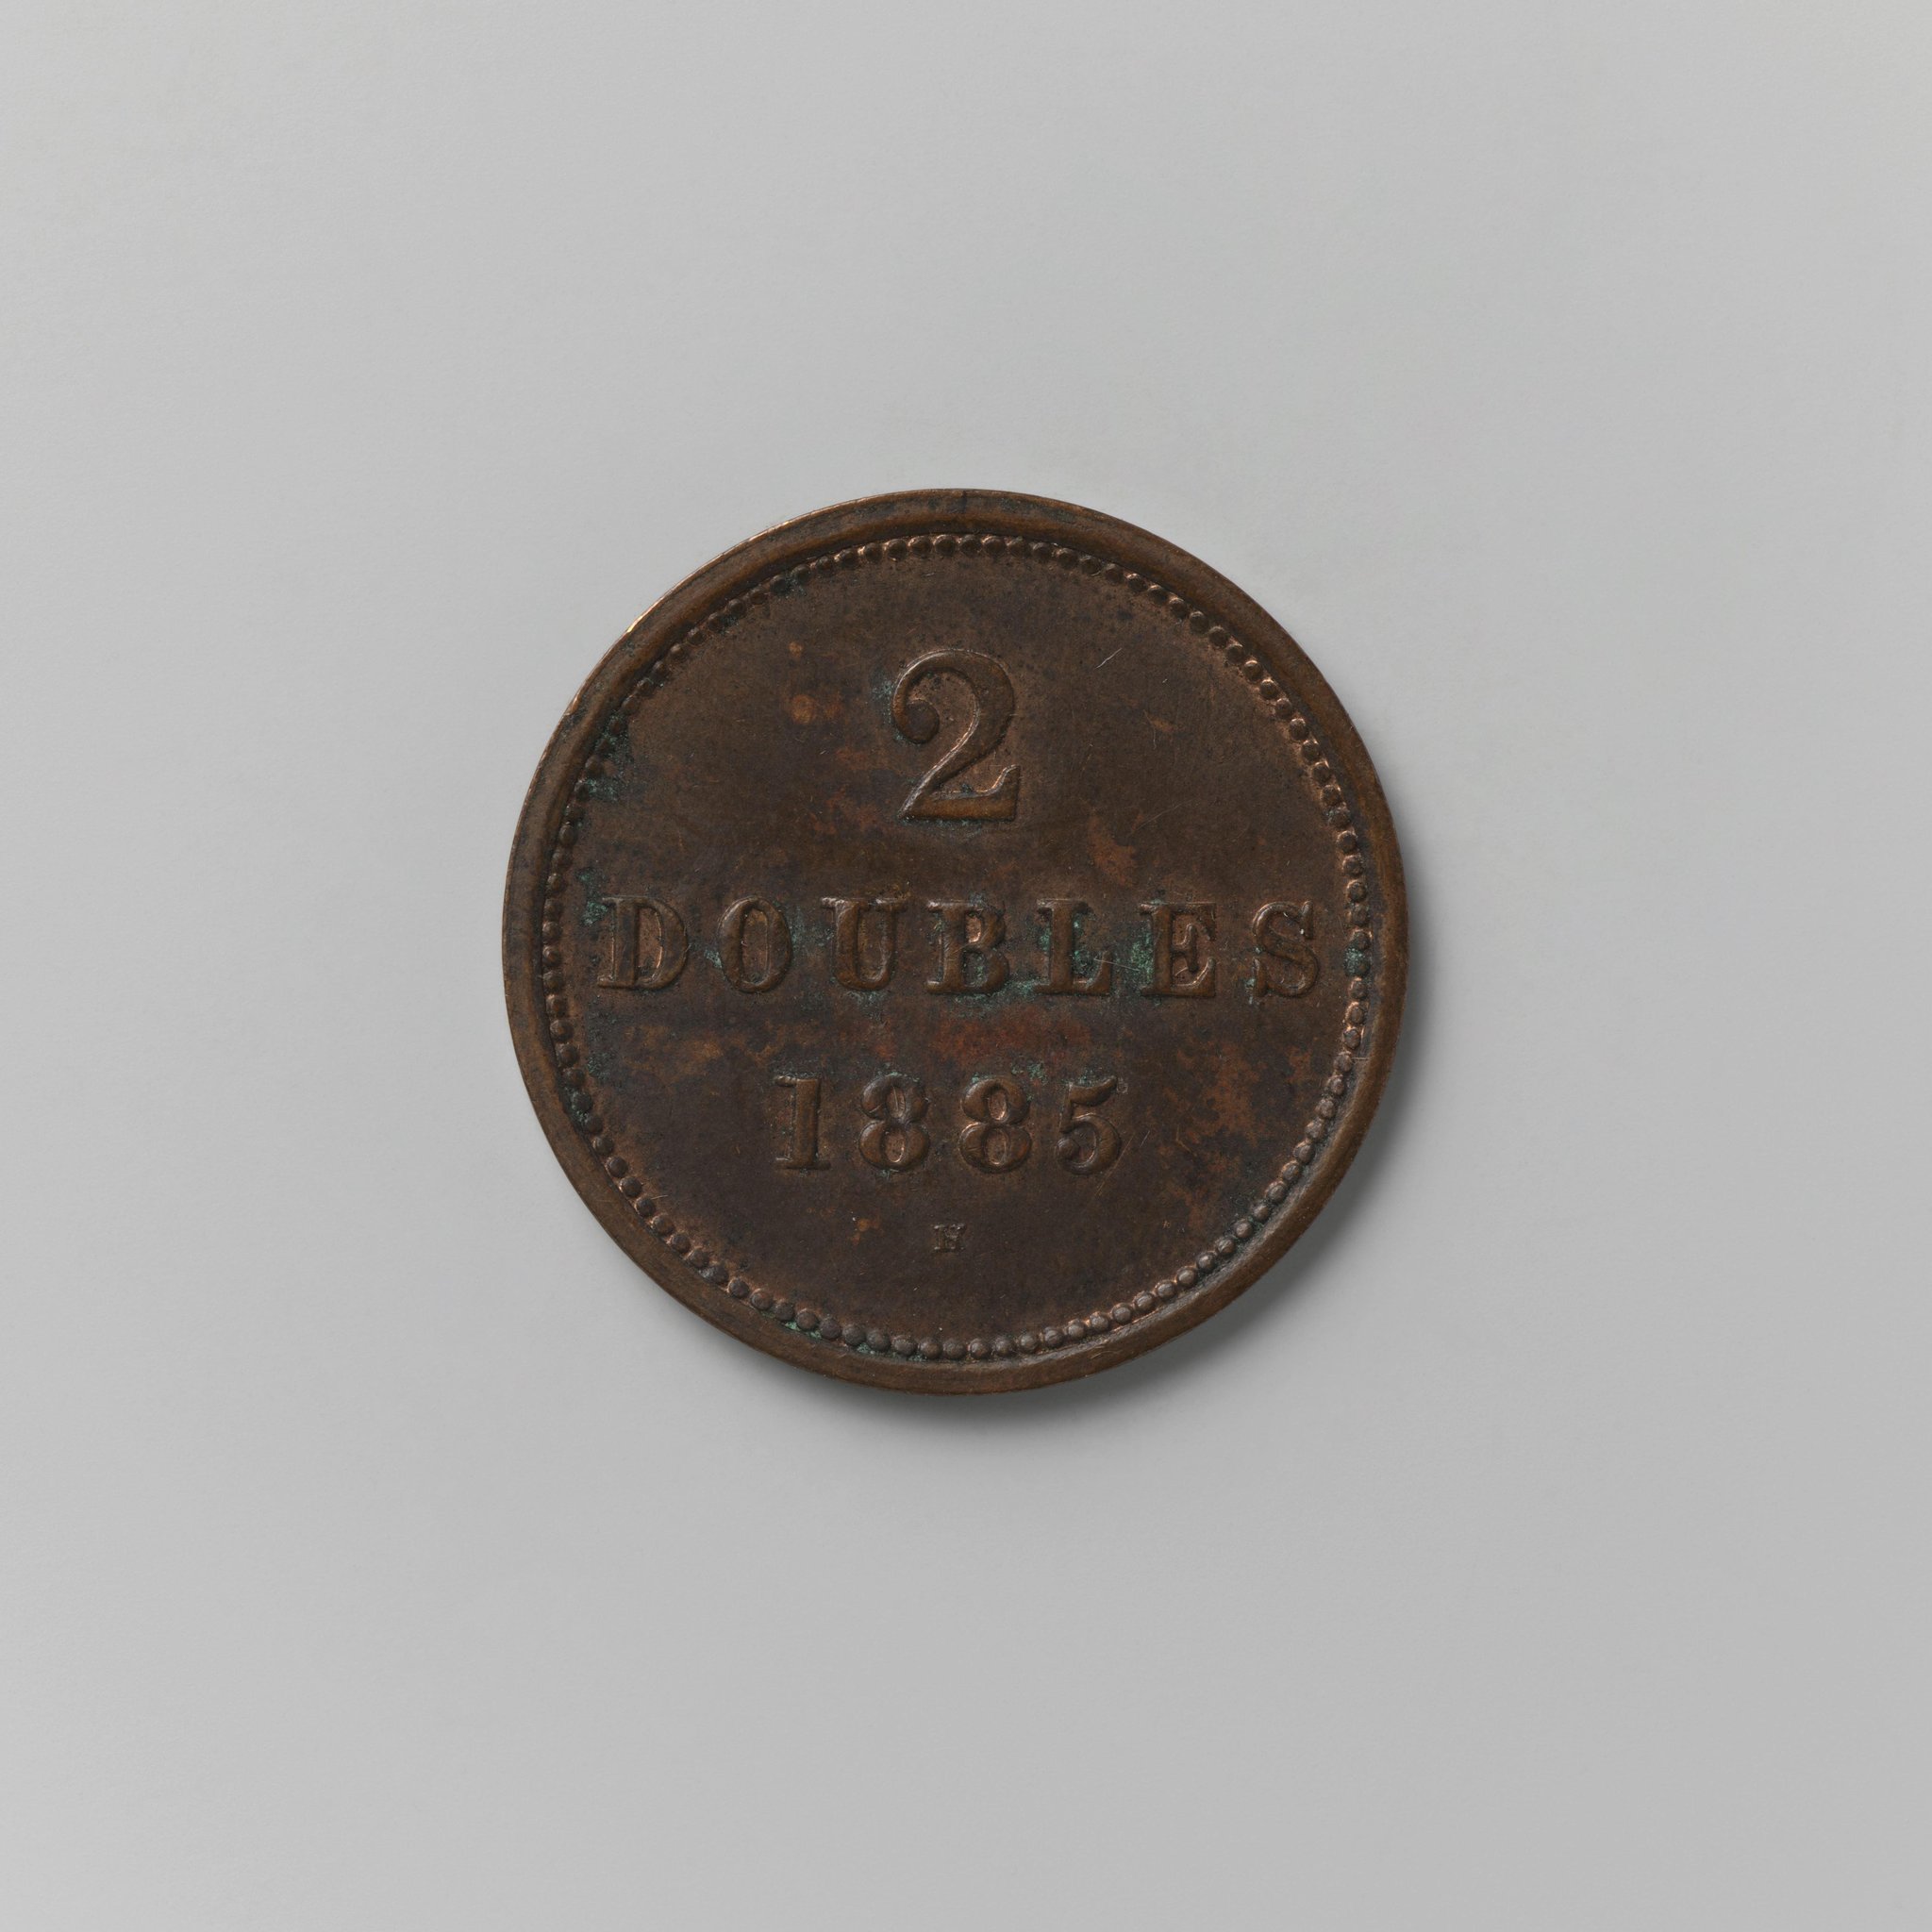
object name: coin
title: Guernsey, Victoria, 2 doubles, 1885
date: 1885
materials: copper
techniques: striking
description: Koperen munt. Voorzijde: wapenschild, waaronder landsaanduiding. Keerzijde: in twee regels waarde-aanduiding, waaronder jaartal. Gladde rand.